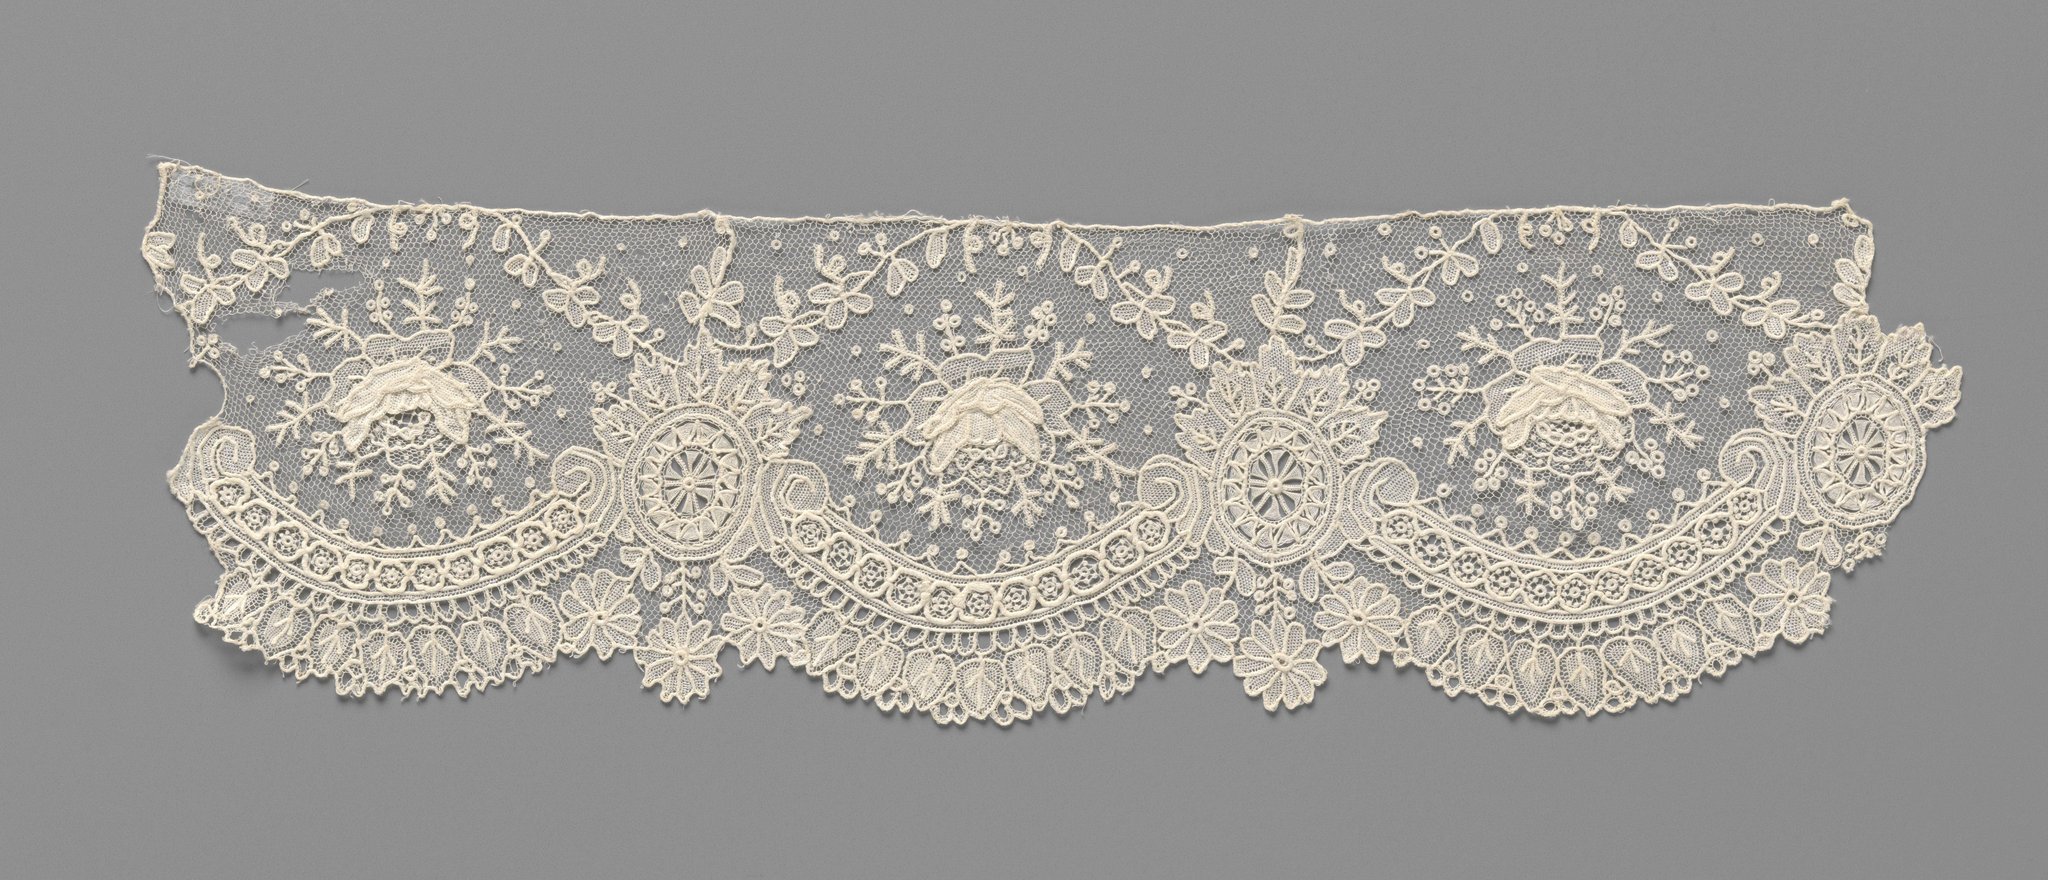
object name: strip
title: Strook naaldkant met hangende hartjes onder liggende c-voluut met roos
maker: Anonymous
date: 1880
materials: linen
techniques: lace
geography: brussels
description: Strook naturelkleurig naaldkant: Brusselse gaaskant. Het zich herhalende patroon bestaat uit grote halfronde schulpen gevormd door aan elkaar geschakelde liggende c-voluten. Boven elk voluut staat één losse roos met een stralenkrans van korte takjes met besjes. De schakelpunten tussen de voluten worden gevormd door ovale medaillons, die met een bladkroon zijn versierd. Vanuit de bladkroon ontspringt een fijn slingertje dat met een boog over de roos naar het volgende medaillon loopt. De schulpenrand wordt gevormd door hangende hartvormige blaadjes onder de voluten afgewisseld door steeds drie afhangende madeliefjes onder de medaillons. De motieven zijn opgebouwd uit festonsteken en voorzien van reliëfcontouren. De rozen hebben reliëfblaadjes. De motieven zijn met elkaar verbonden door een fijne maasgrond, een gaaskantgrond, waarop enkele moesjes zijn aangebracht. In de rozen en medaillons zijn siersteken toegepast. De bovenzijde van de strook is recht afgewerkt.